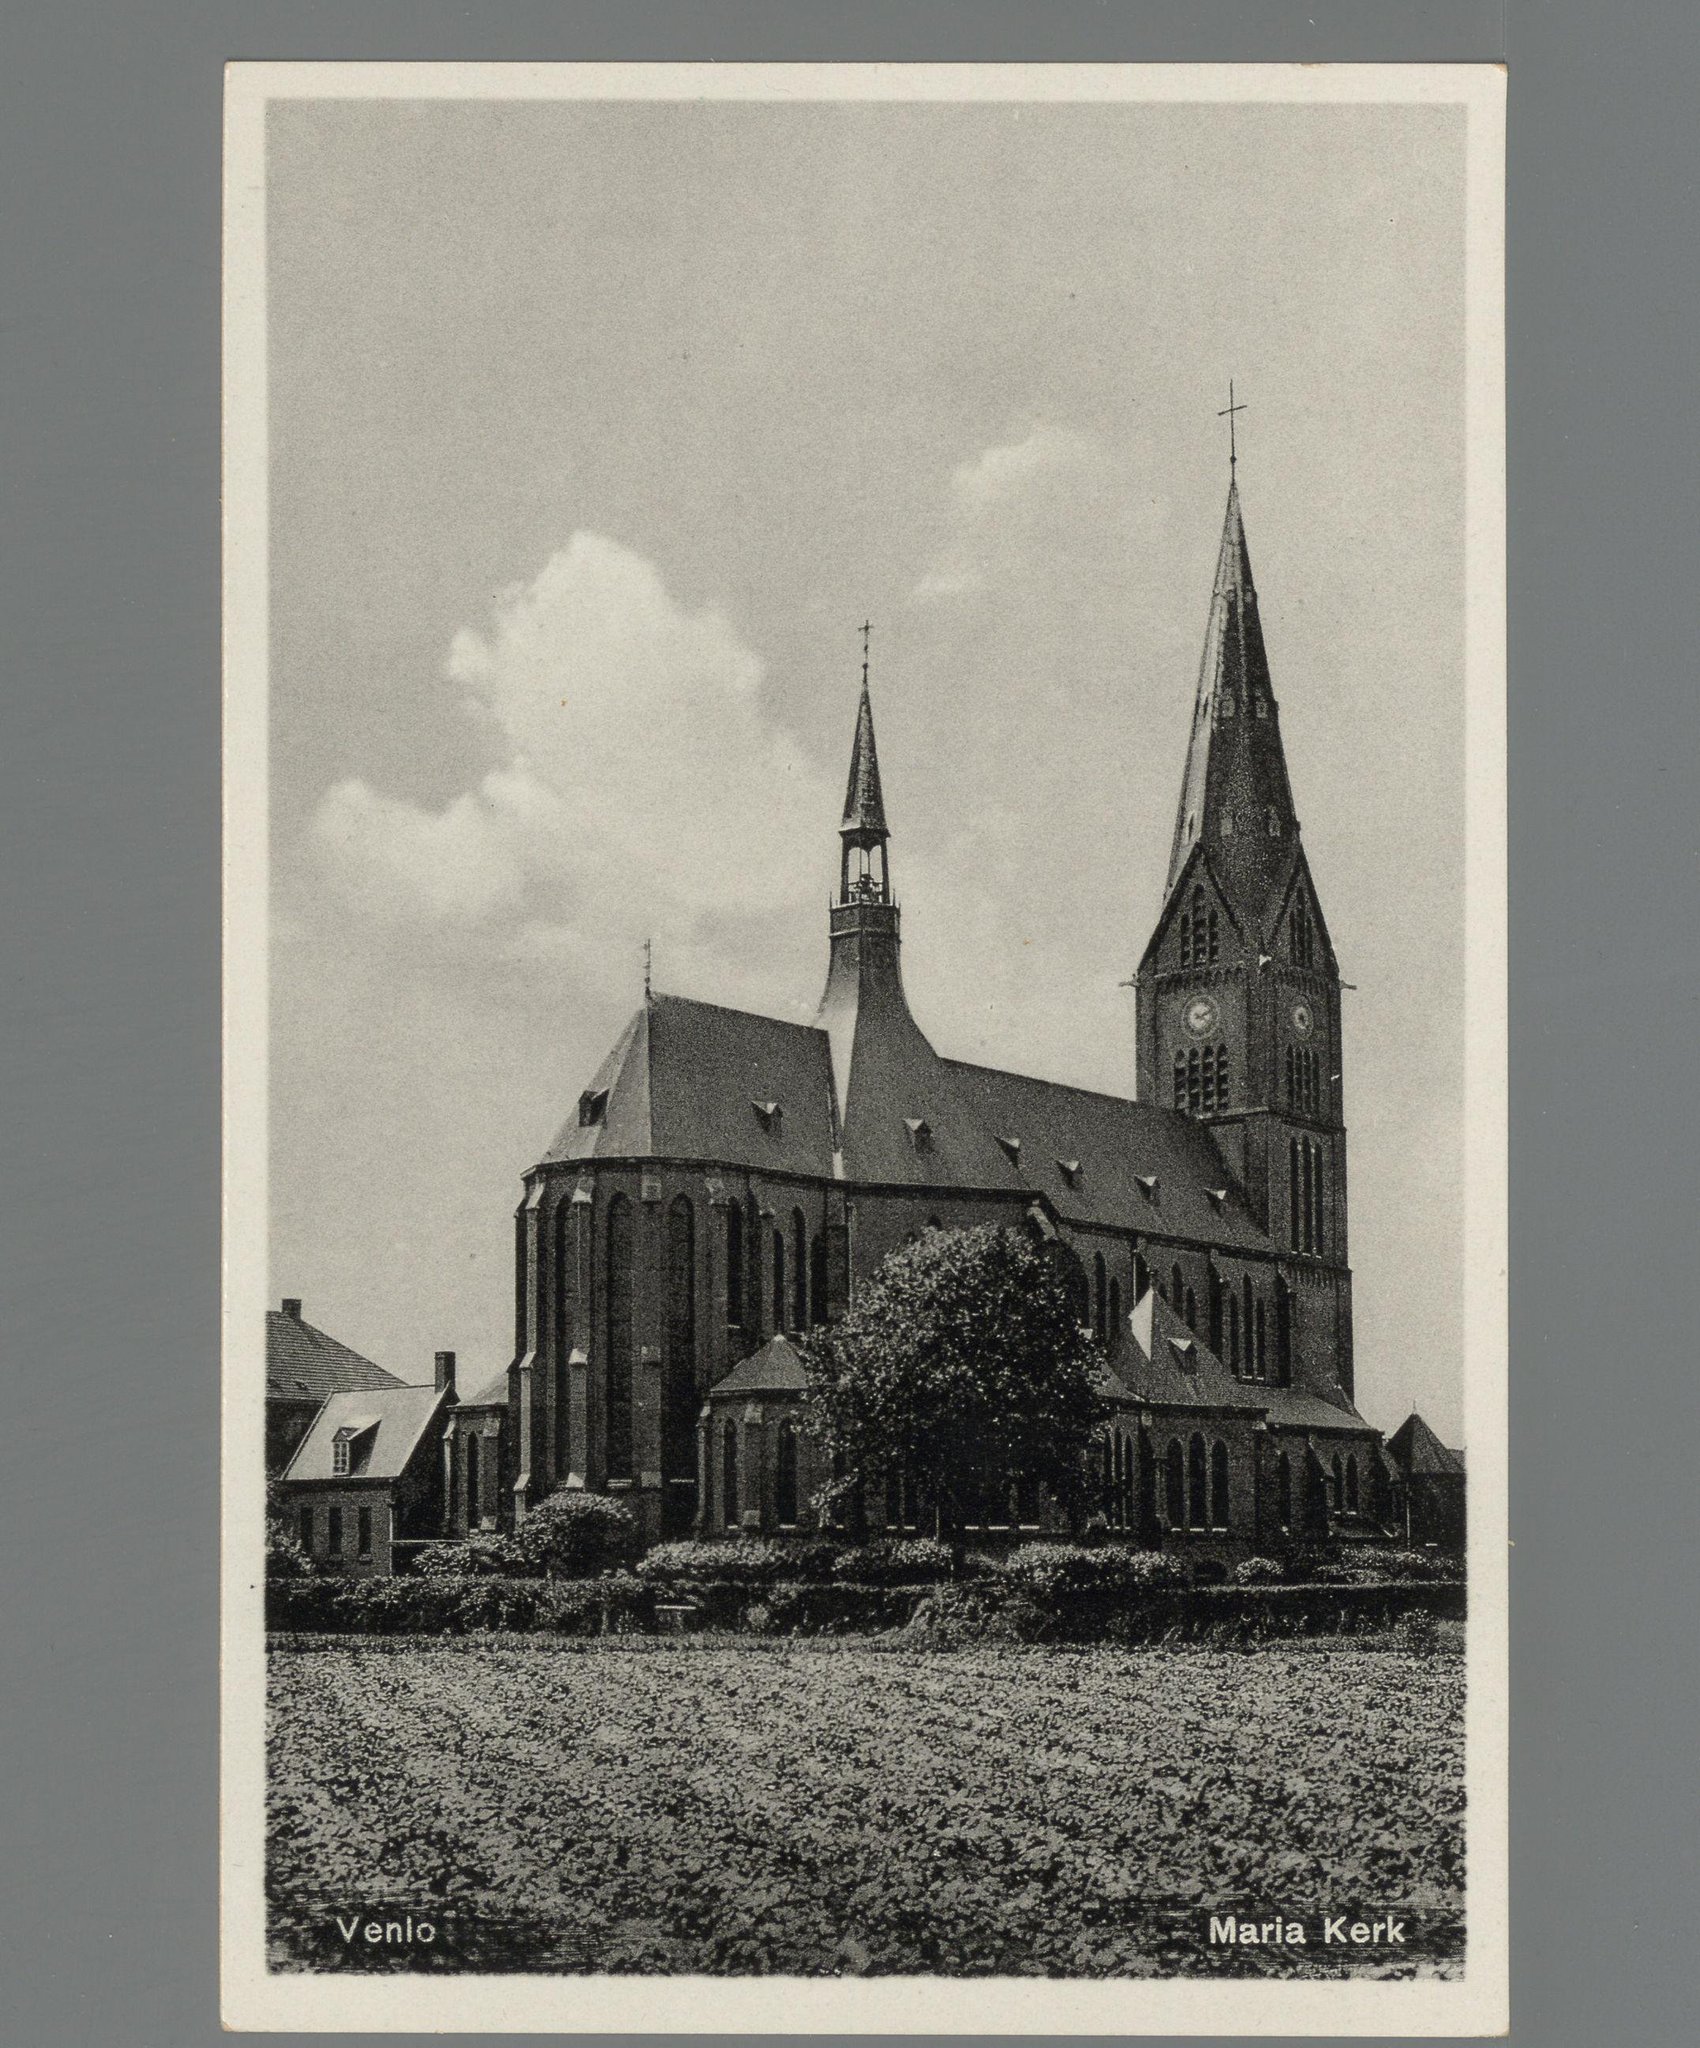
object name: photomechanical print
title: Venlo. Maria Kerk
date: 1913-1950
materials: cardboard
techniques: photograph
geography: venlo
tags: church (exterior)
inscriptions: monogram: ‘L.D.’